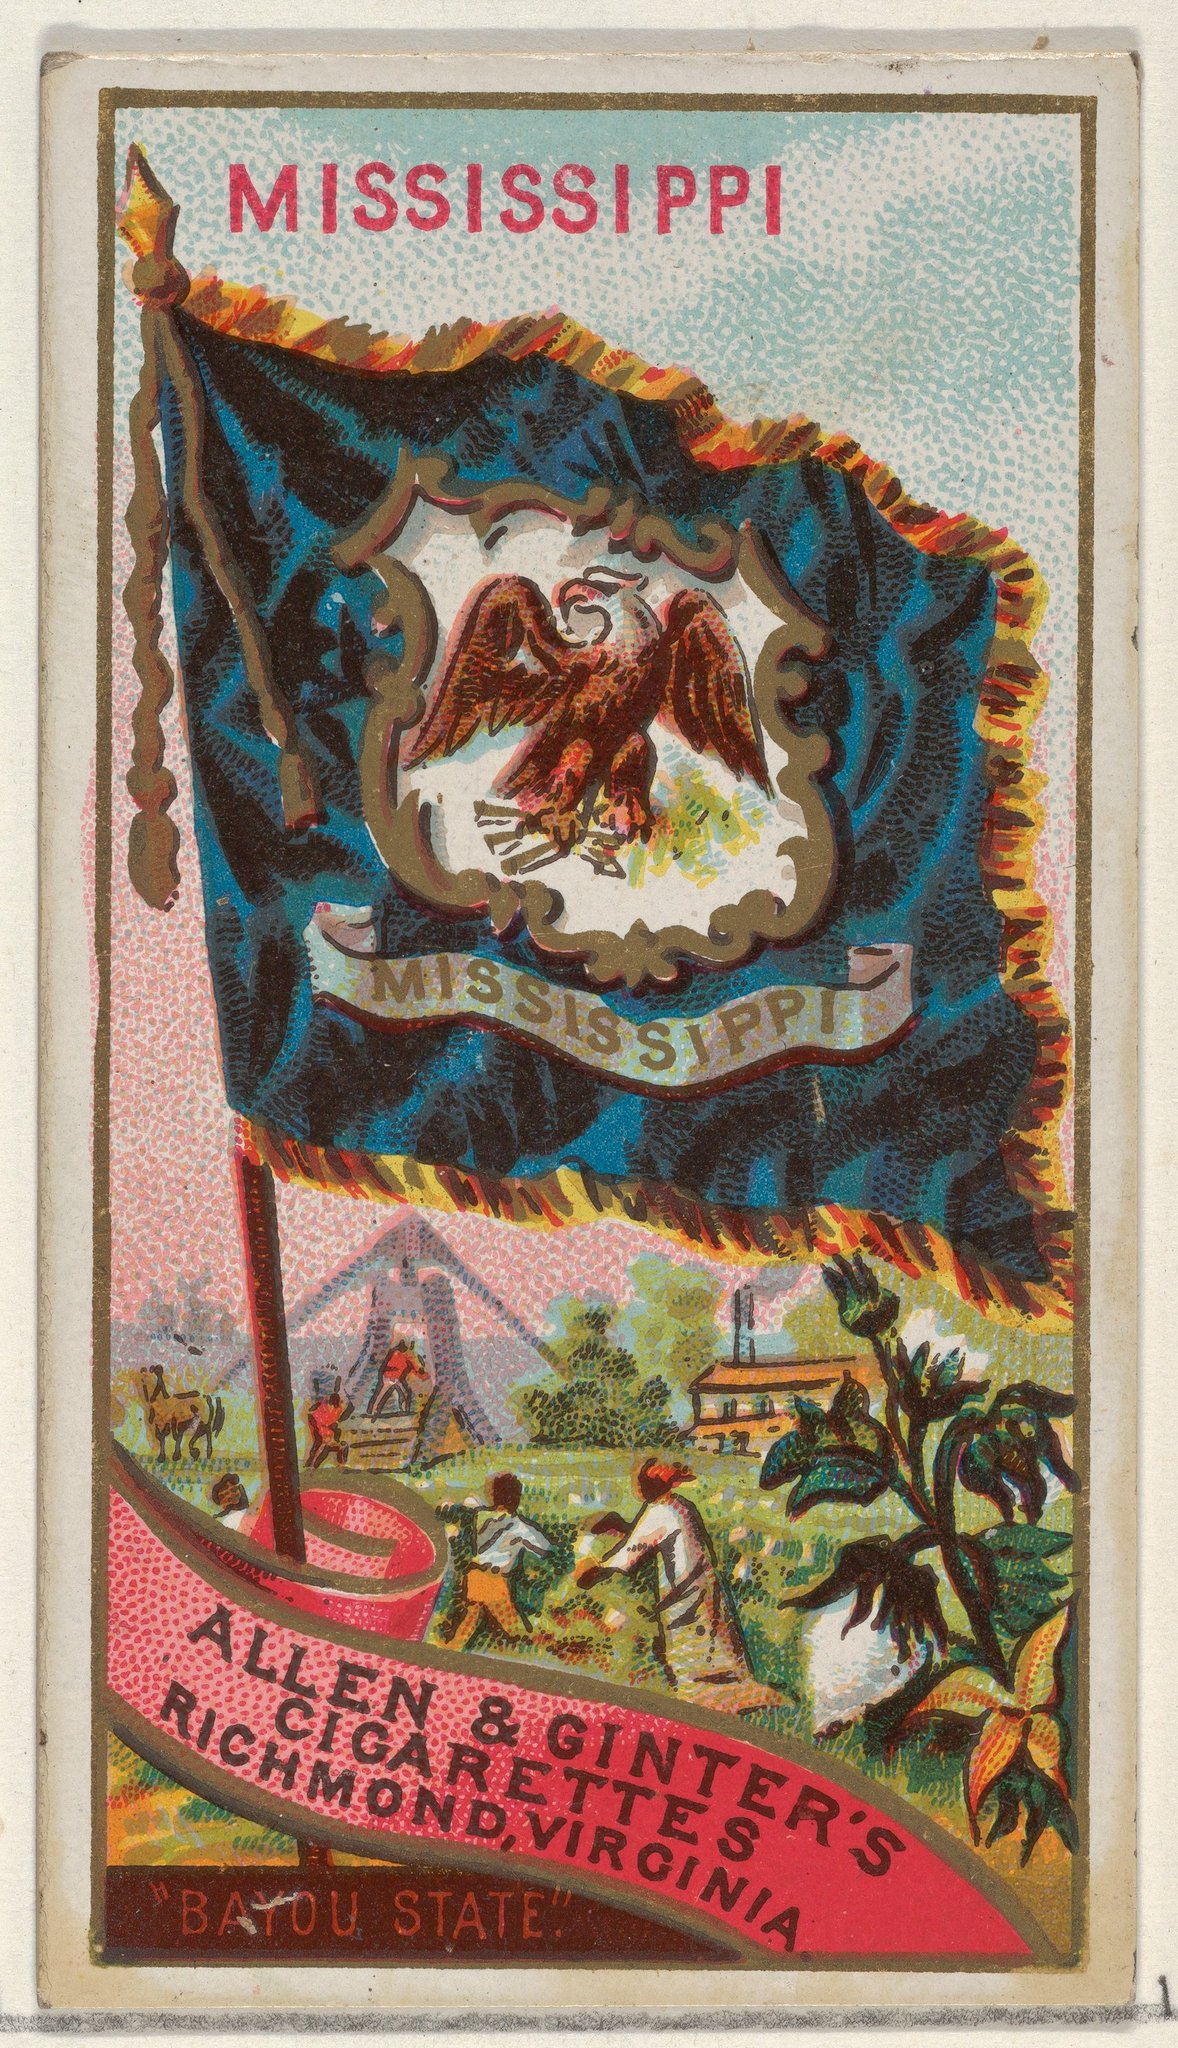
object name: print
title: Mississippi, from Flags of the States and Territories (N11) for Allen & Ginter Cigarettes Brands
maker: allen & ginter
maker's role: publisher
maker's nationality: american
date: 1888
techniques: color lithograph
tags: flags